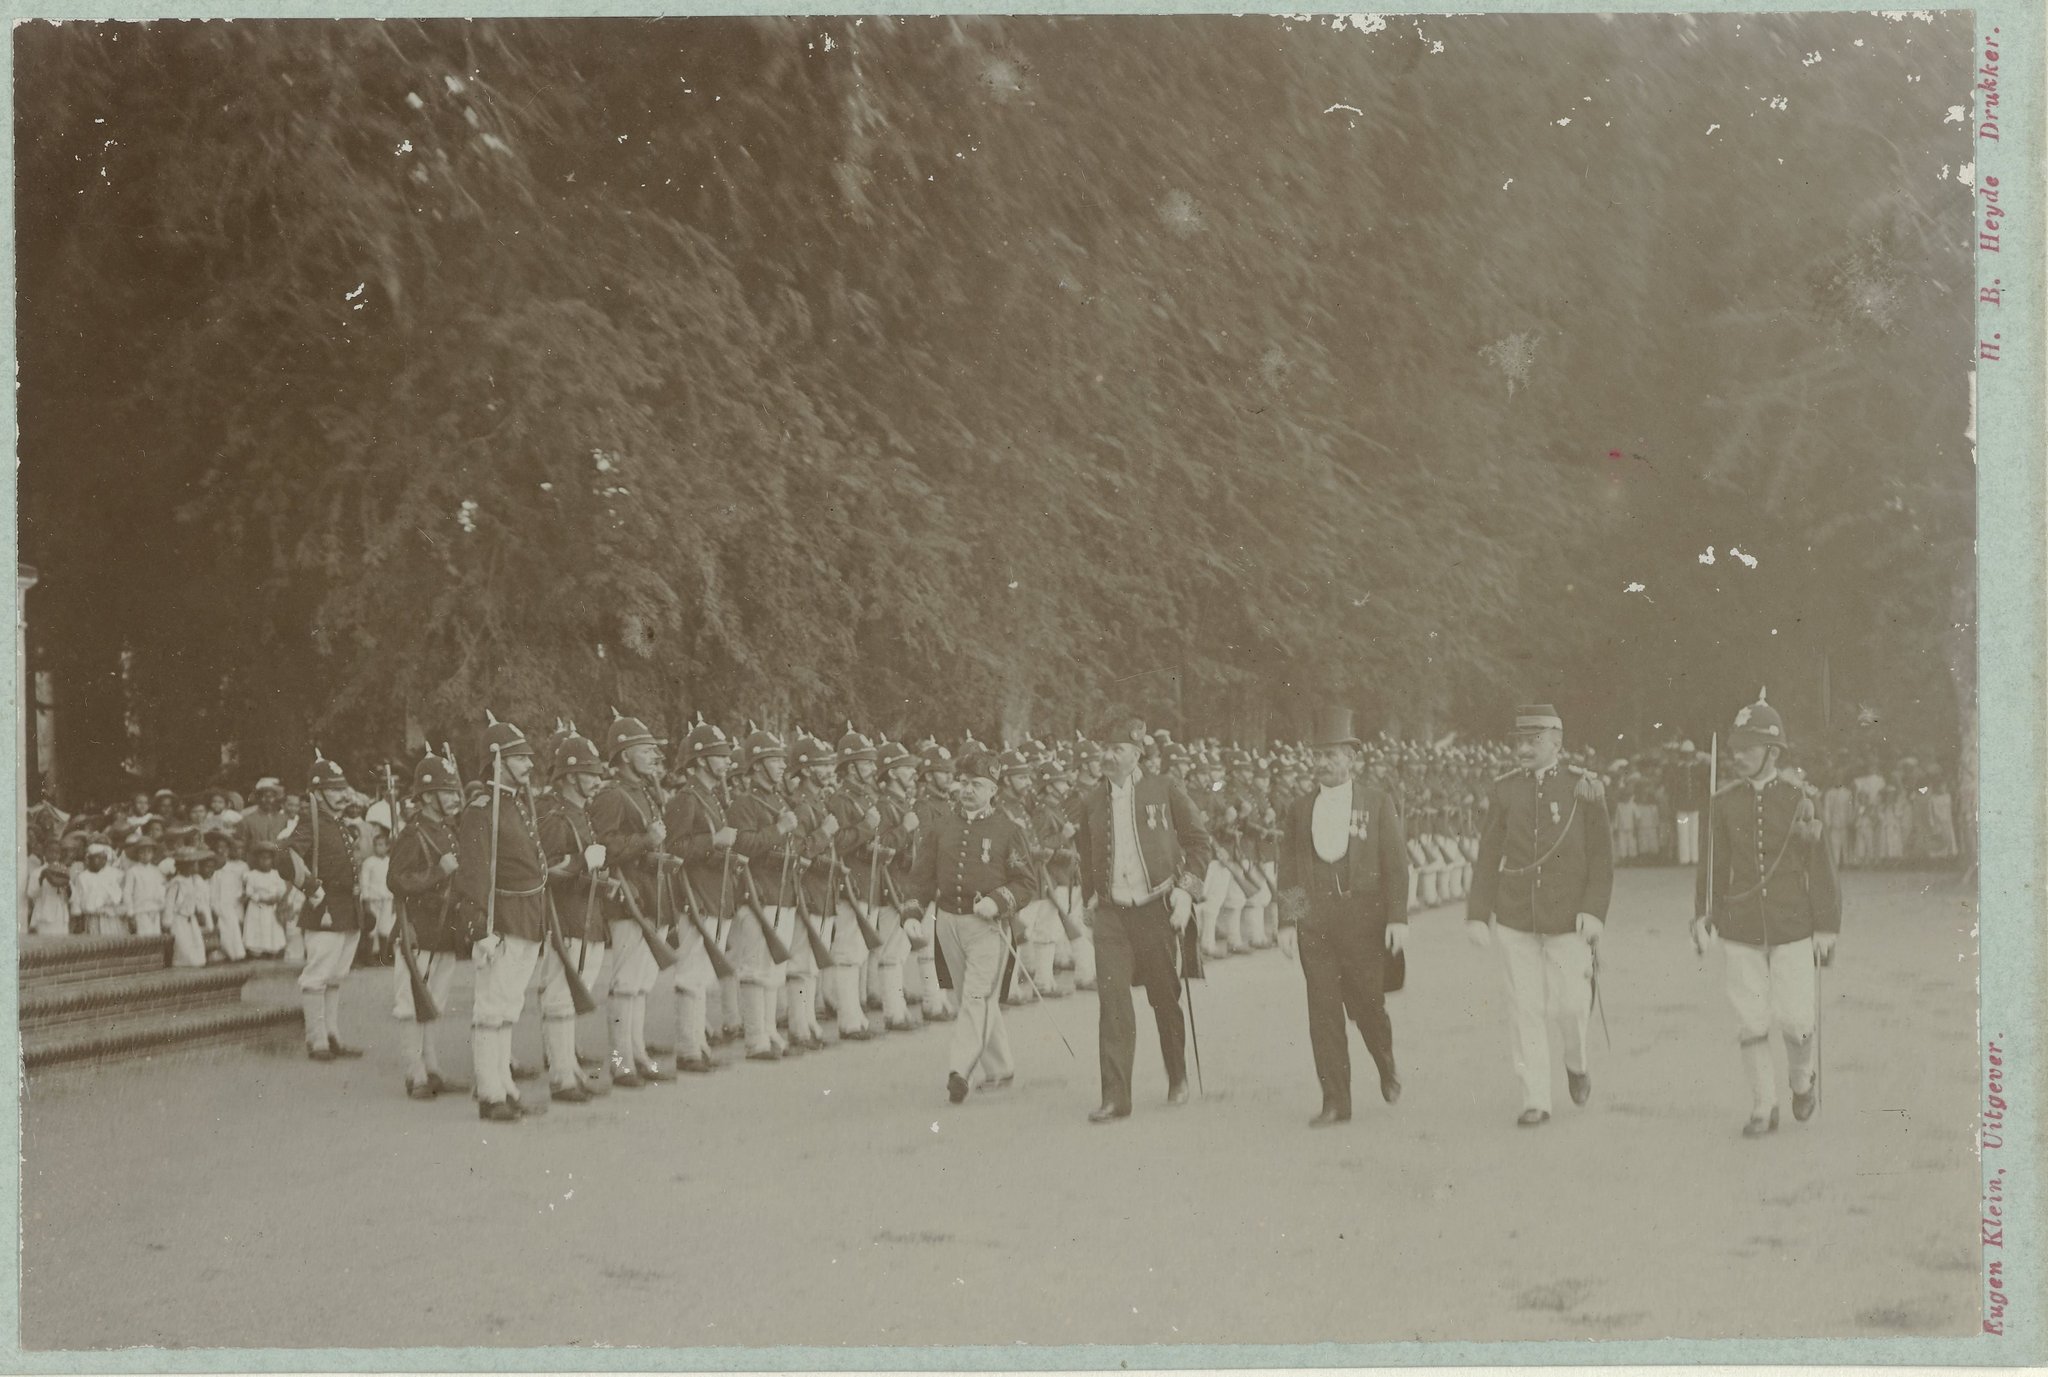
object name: photograph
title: Koninginnedag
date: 1903-1908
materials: photographic support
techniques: photography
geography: paramaribo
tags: meppel, tiel, rechter, jurist, gouverneur, procureur-generaal, advocaat-generaal, petrus hofstede crull, paramaribo (stad), koninginnedag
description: Optocht ter ere van Koninginnedag in Paramaribo, mogelijk 1908. Langs de kant staan militairen. Vijf heren lopen langs, waaronder Hofstede Crull. Misschien omdat hij toen waarnemend Gouverneur van Suriname was.